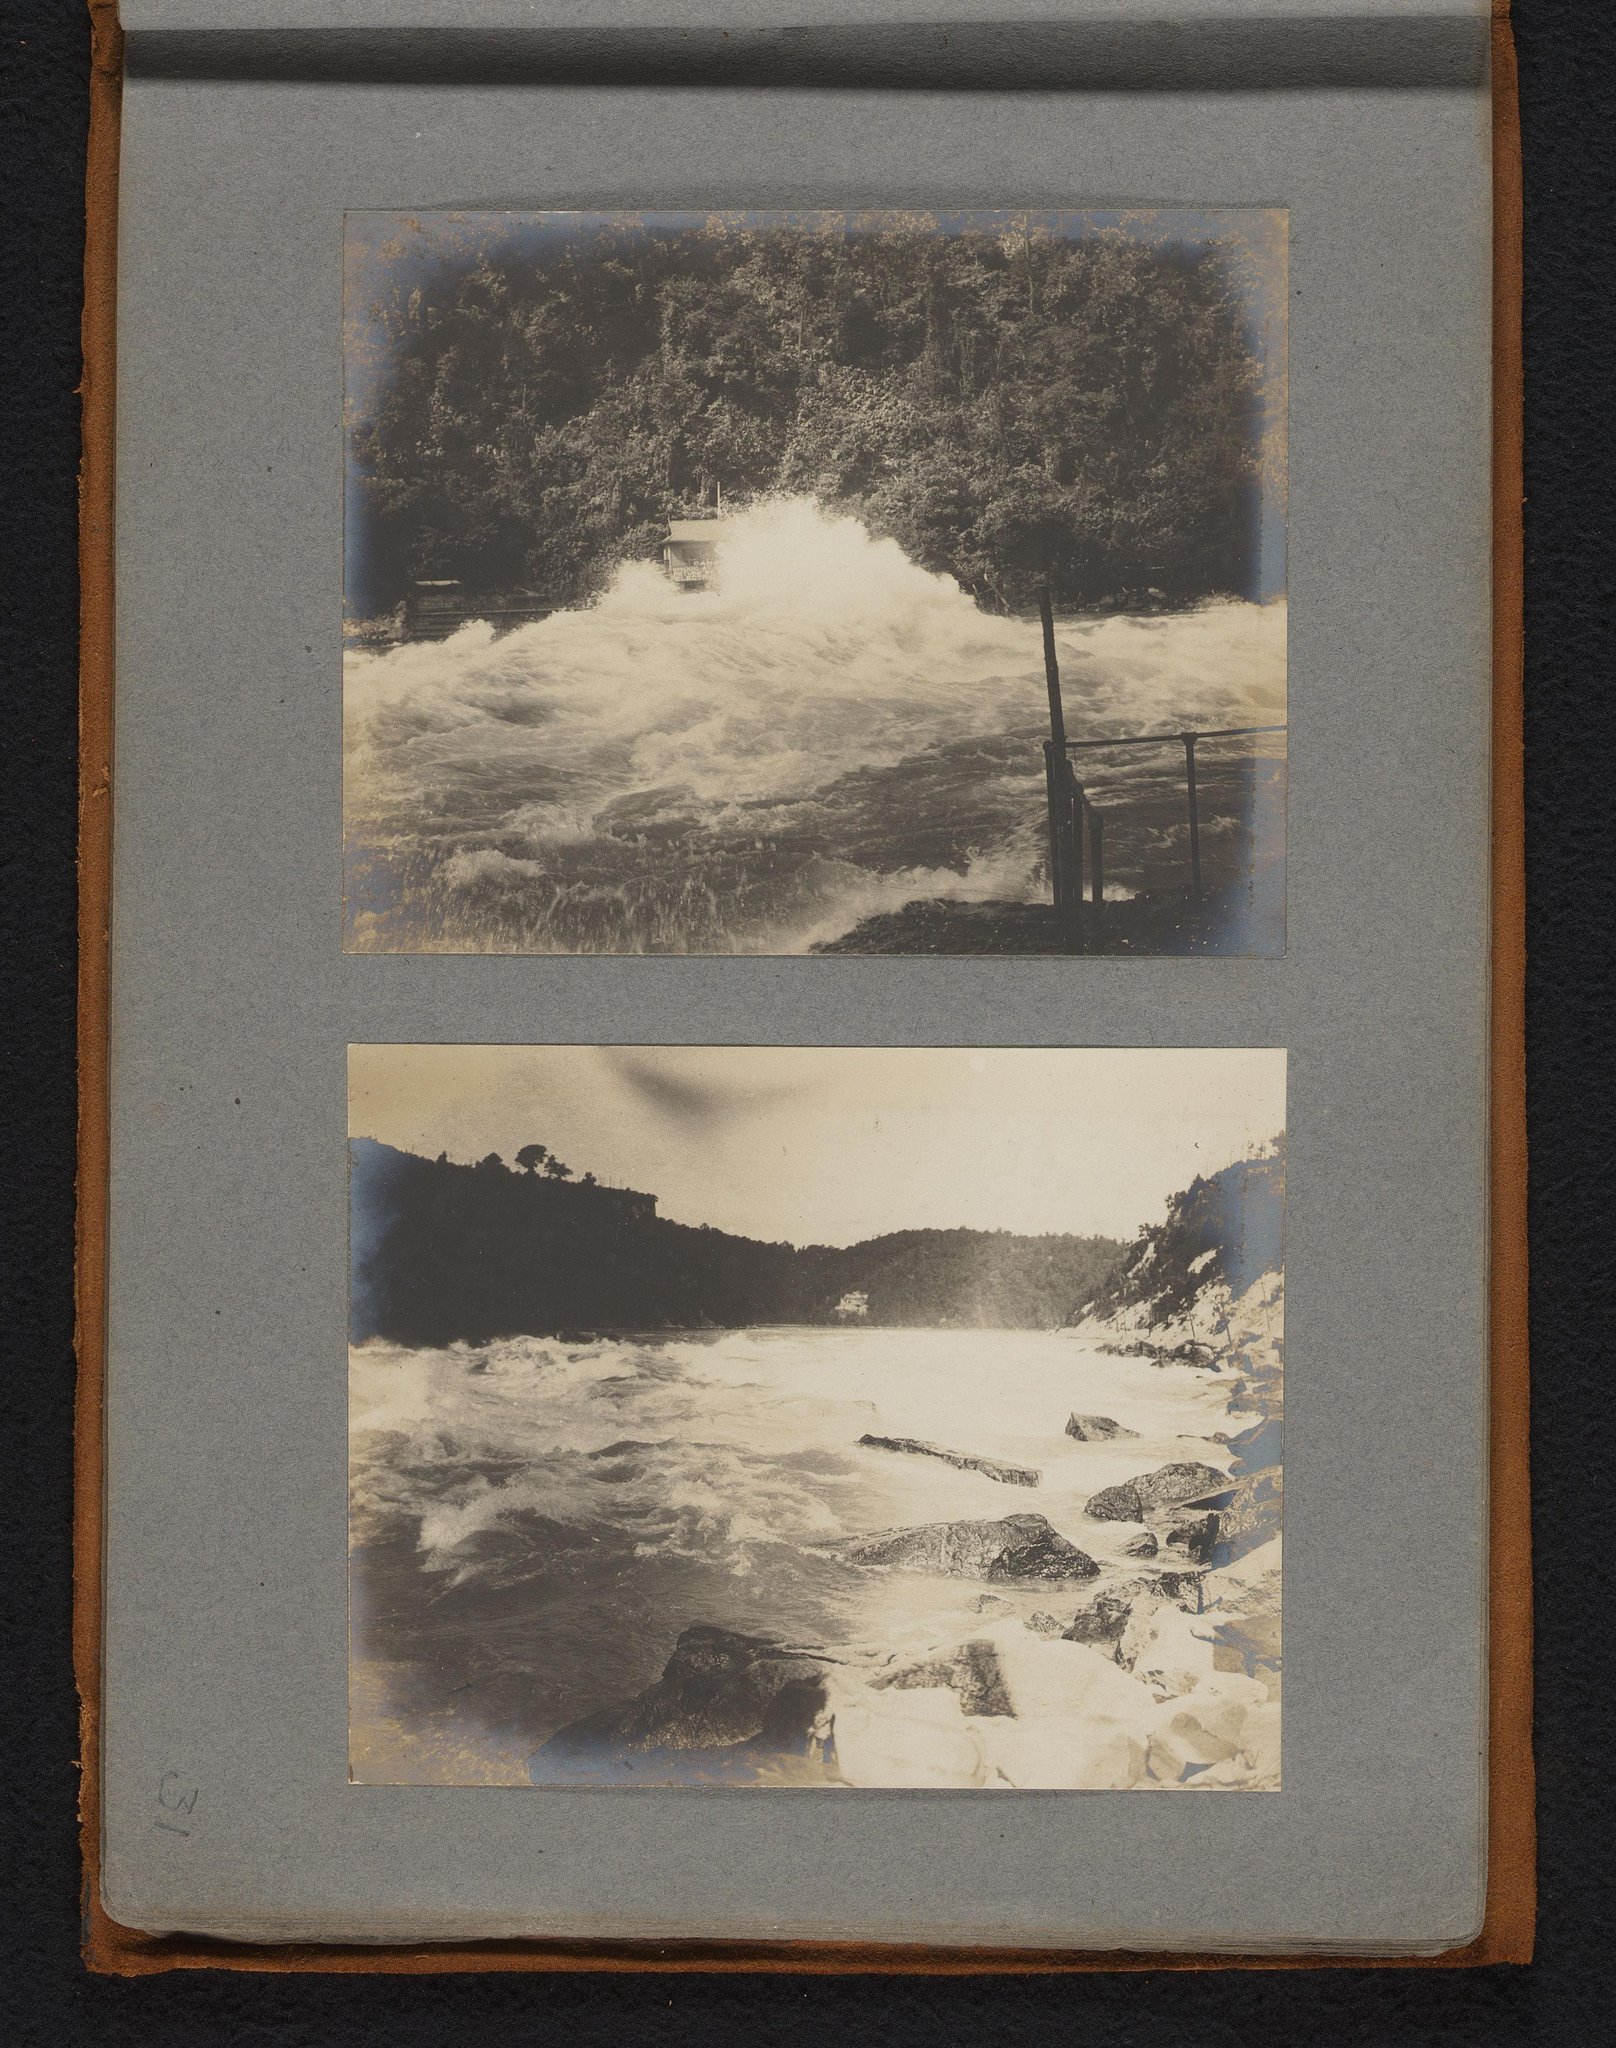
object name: album leaf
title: Landschap met een golvende rivier, mogelijk de Niagara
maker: jan van der mey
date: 1902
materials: paper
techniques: gelatin silver print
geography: north america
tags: rapids, river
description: Deze foto's maken deel uit van een album.